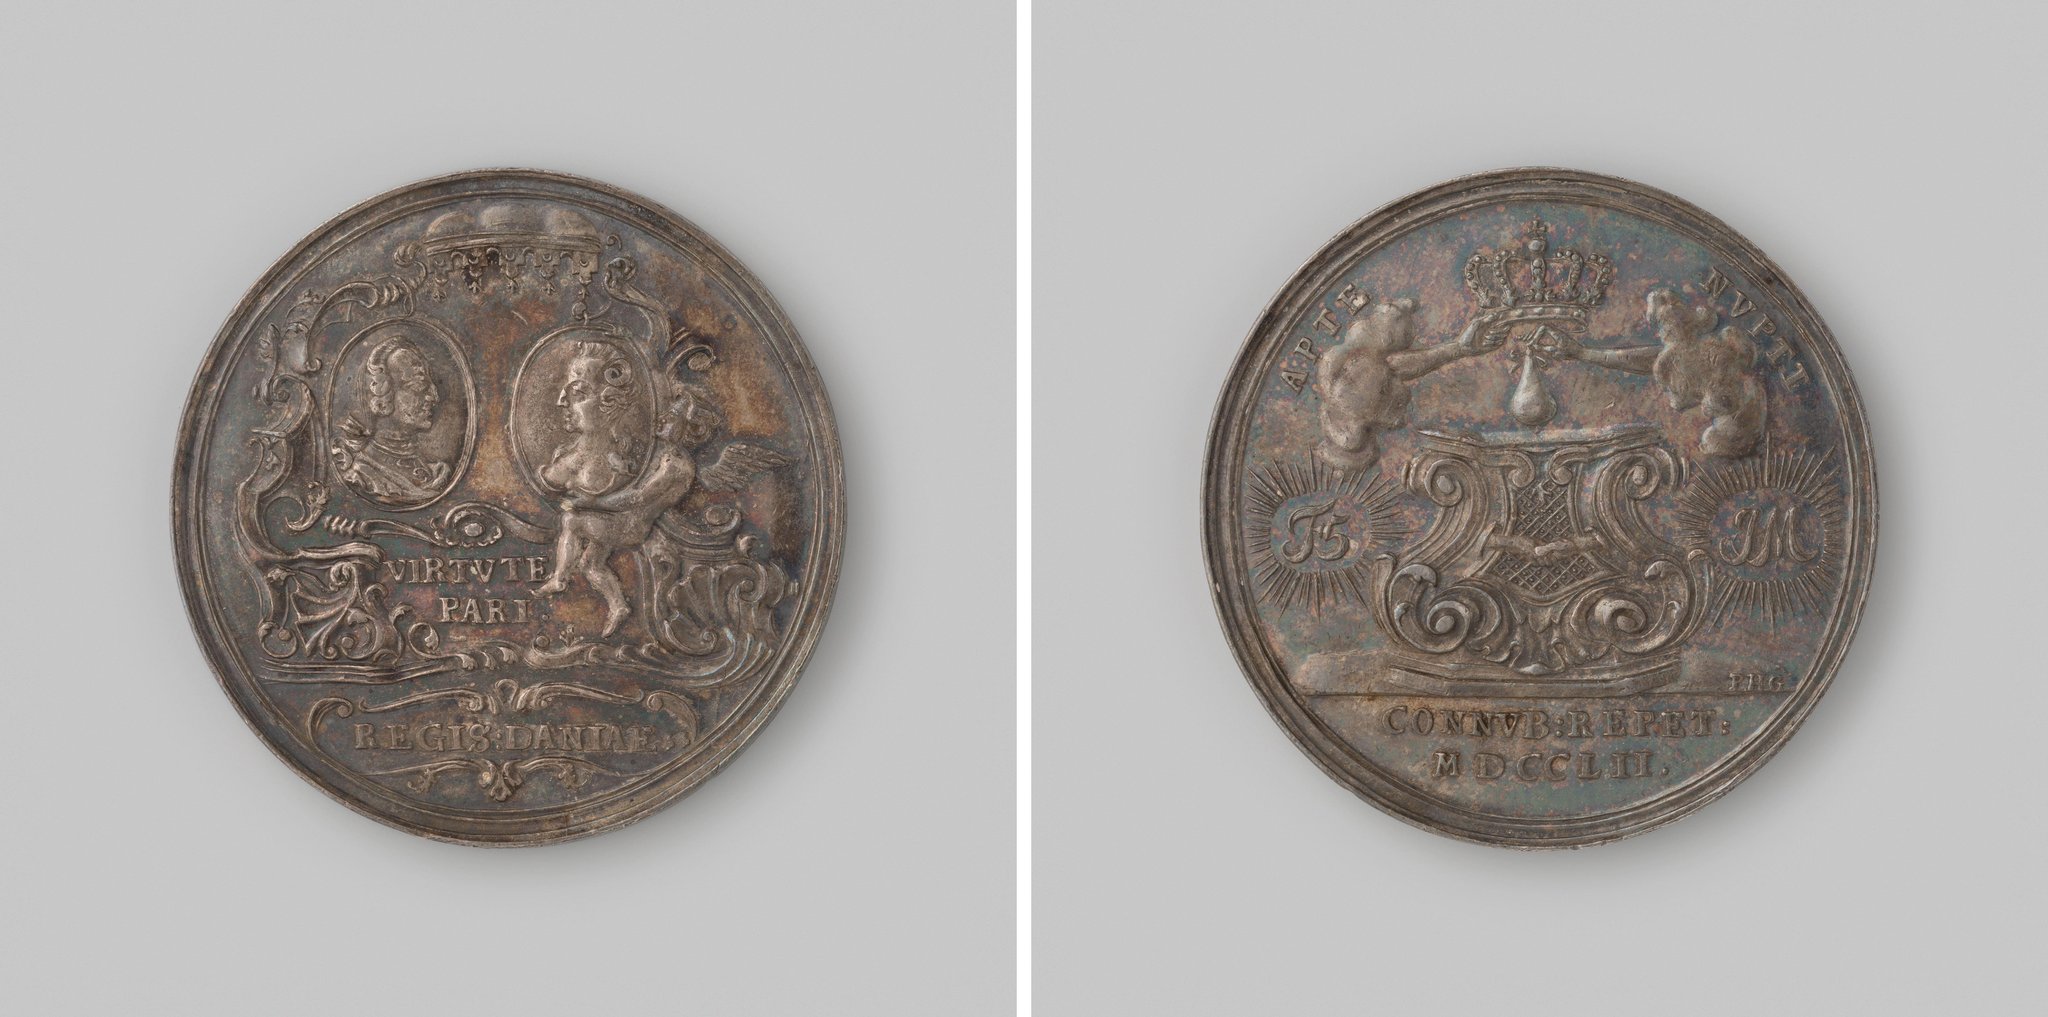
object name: history medal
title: Huwelijk van Frederik V van Denemerken met Juliana Maria van Brunswijk-Wolfenbüttel 1752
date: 1752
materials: silver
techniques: striking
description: Zilveren penning, op de voorzijde ovale portretmedaillons van het echtpaar onder een kroon, die van de vrouw wordt door een engel aangedragen, binnen ornamentale versiering, op de keerzijde een arm uit een wolk gemerkt F5 houdt een kroon boven een tweede arm met buidel uit een wolk gemerkt JM, boven een altaar, met omschrift en afsnedetekst.